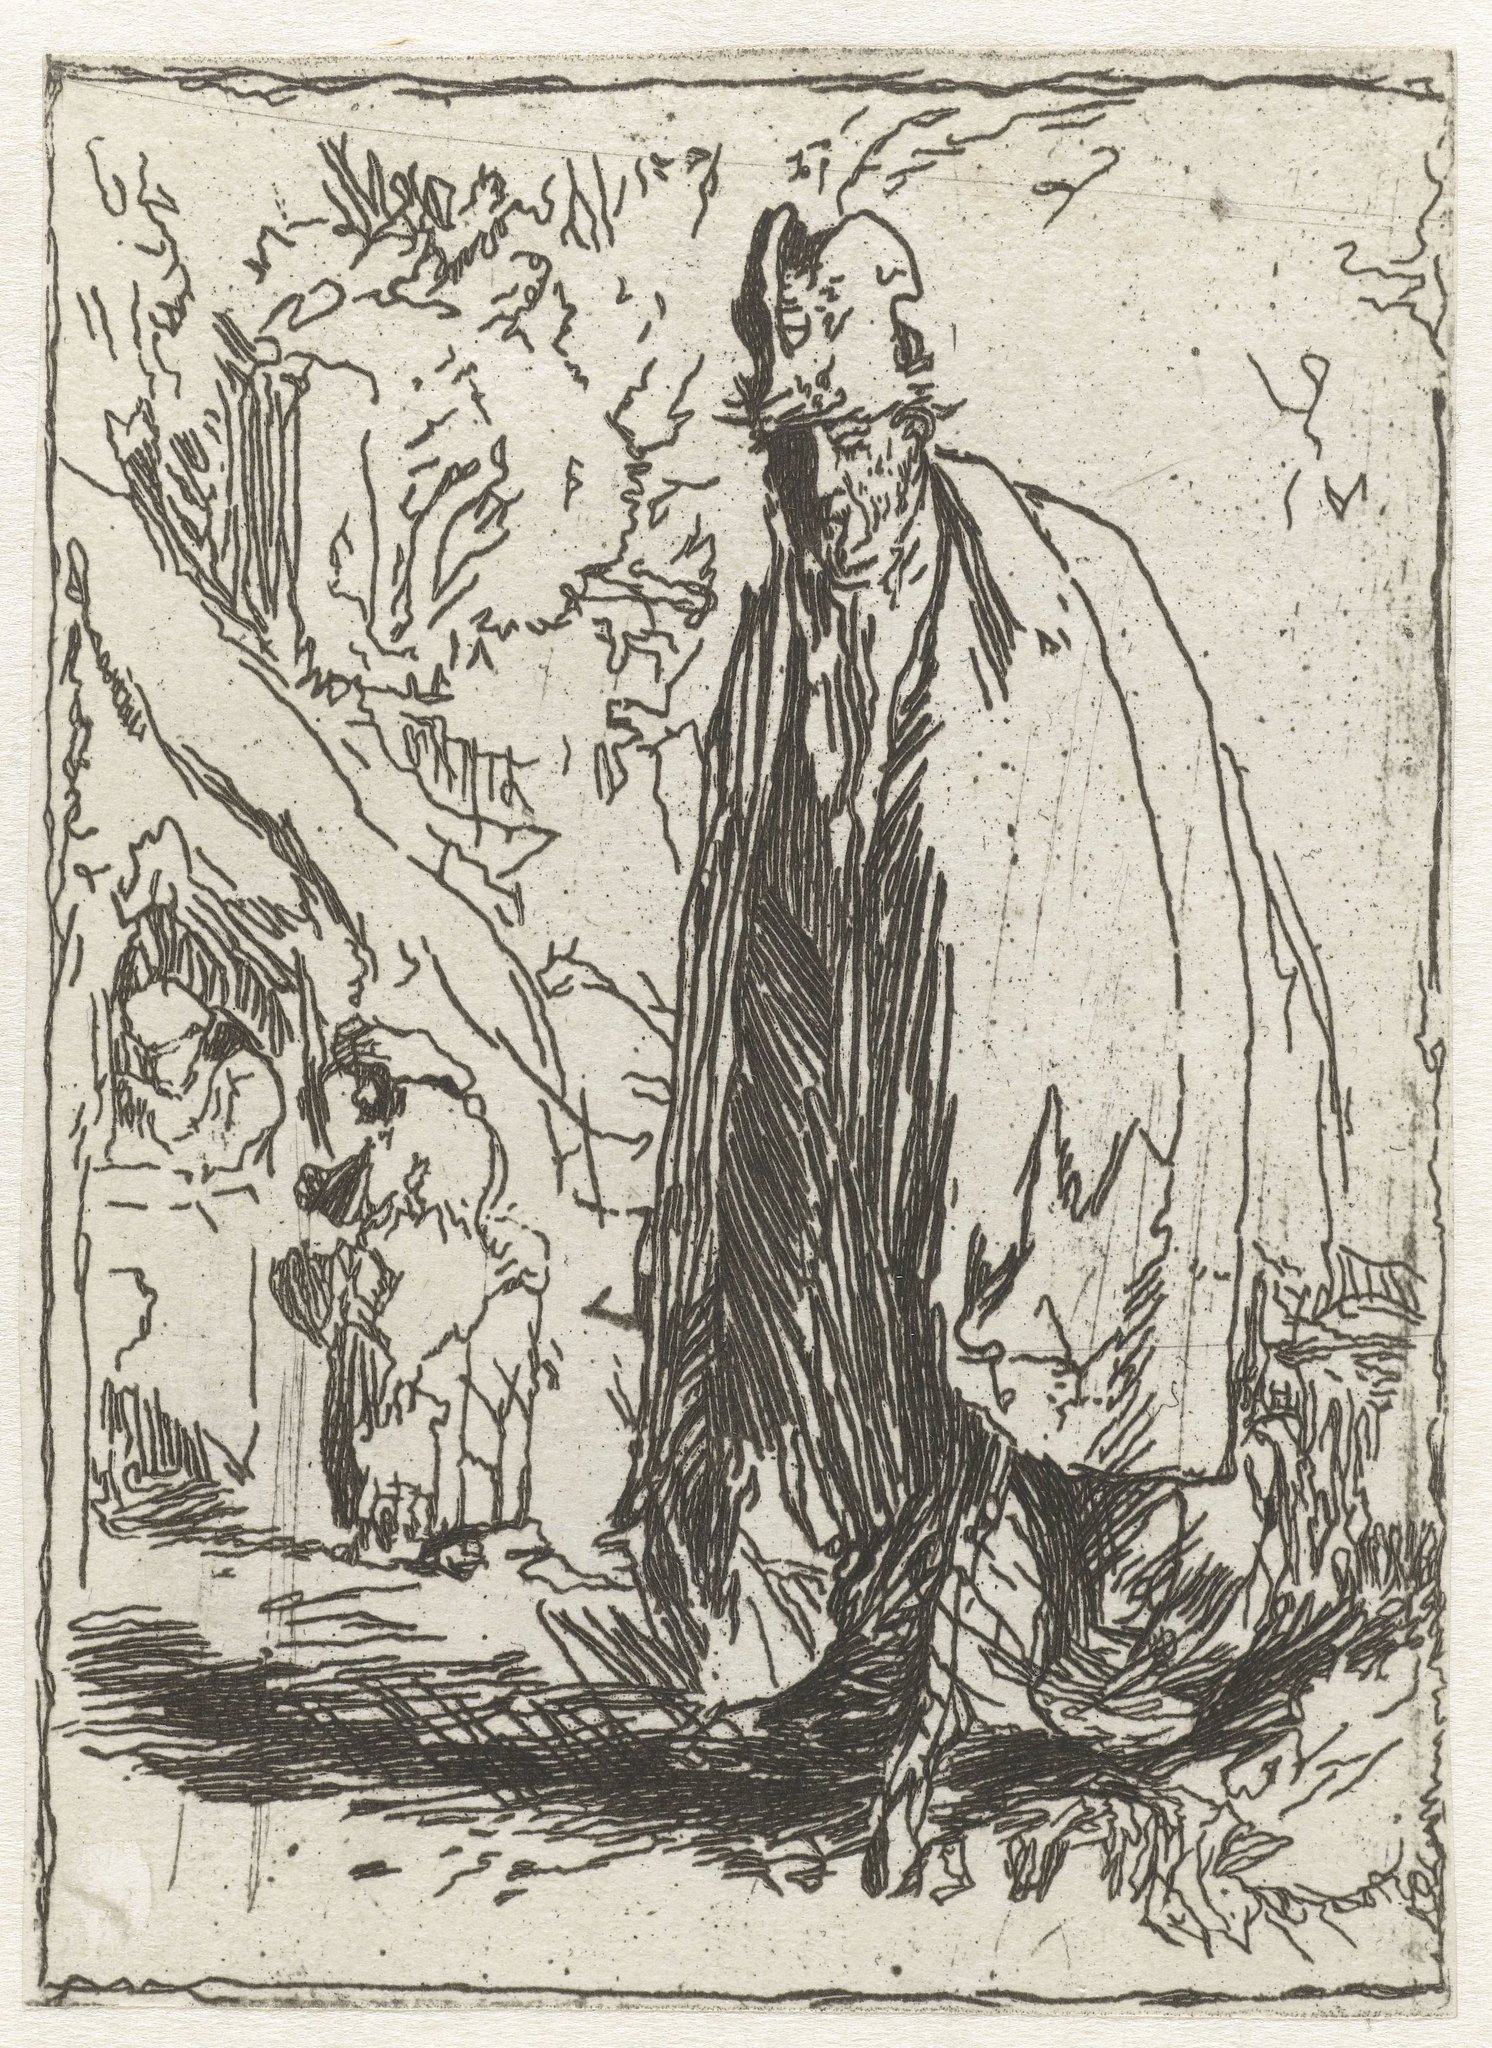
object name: print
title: A beggar in a tall hat and long cloak, with a cottage and two figures in the background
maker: léopold flameng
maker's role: print maker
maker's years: 1831-1911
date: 1841-1911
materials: paper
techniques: etching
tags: beggar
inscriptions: collector's mark: Lugt 2228